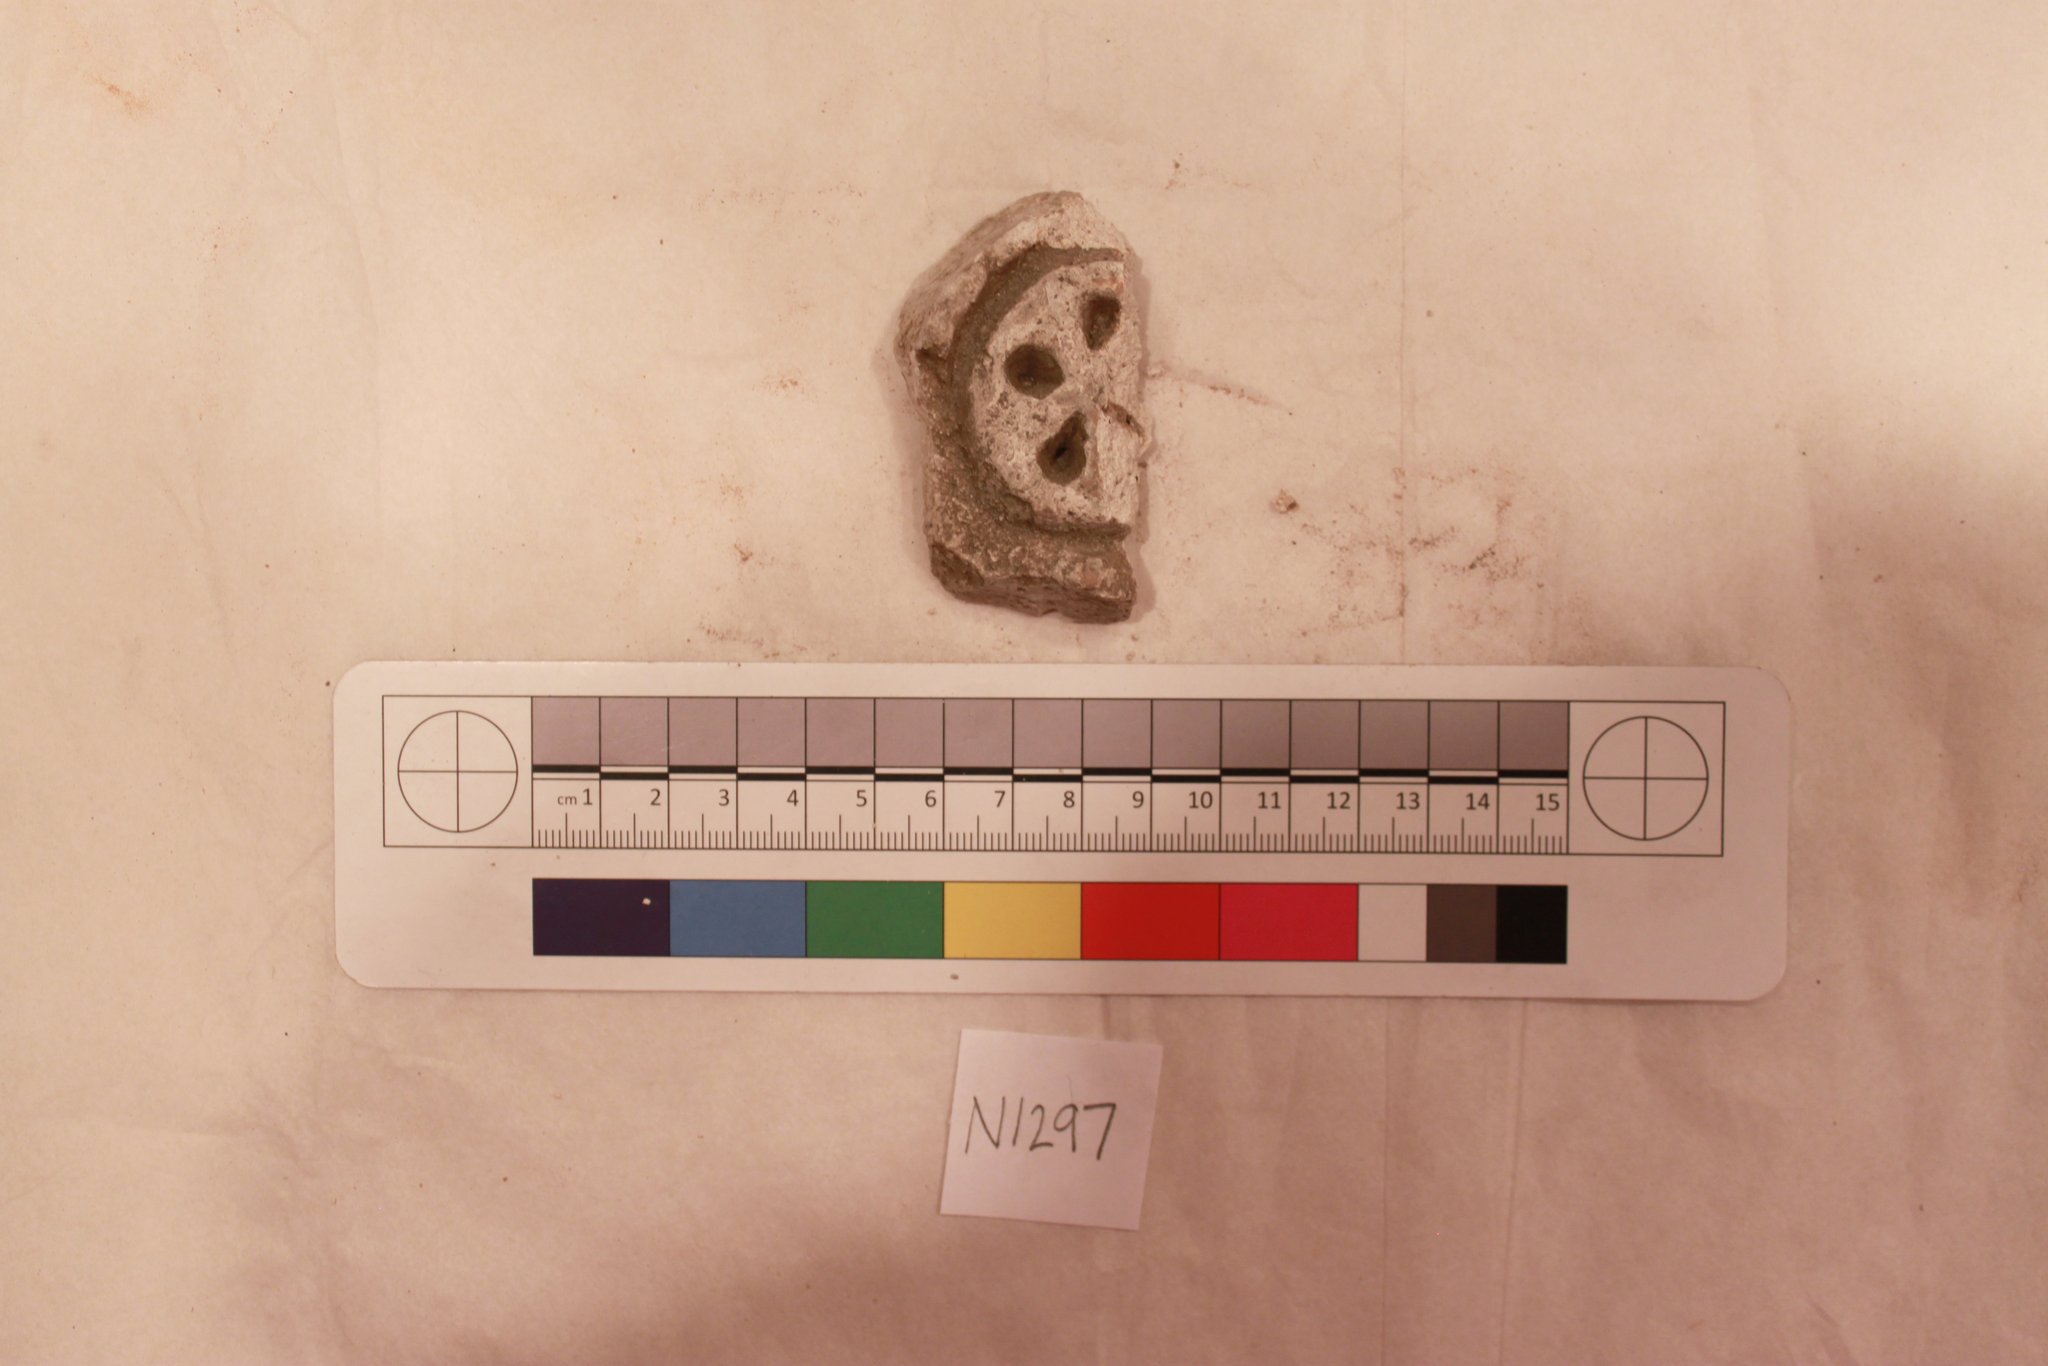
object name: fragment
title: Stucco Fragment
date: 701-1200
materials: plaster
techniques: carving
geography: iran